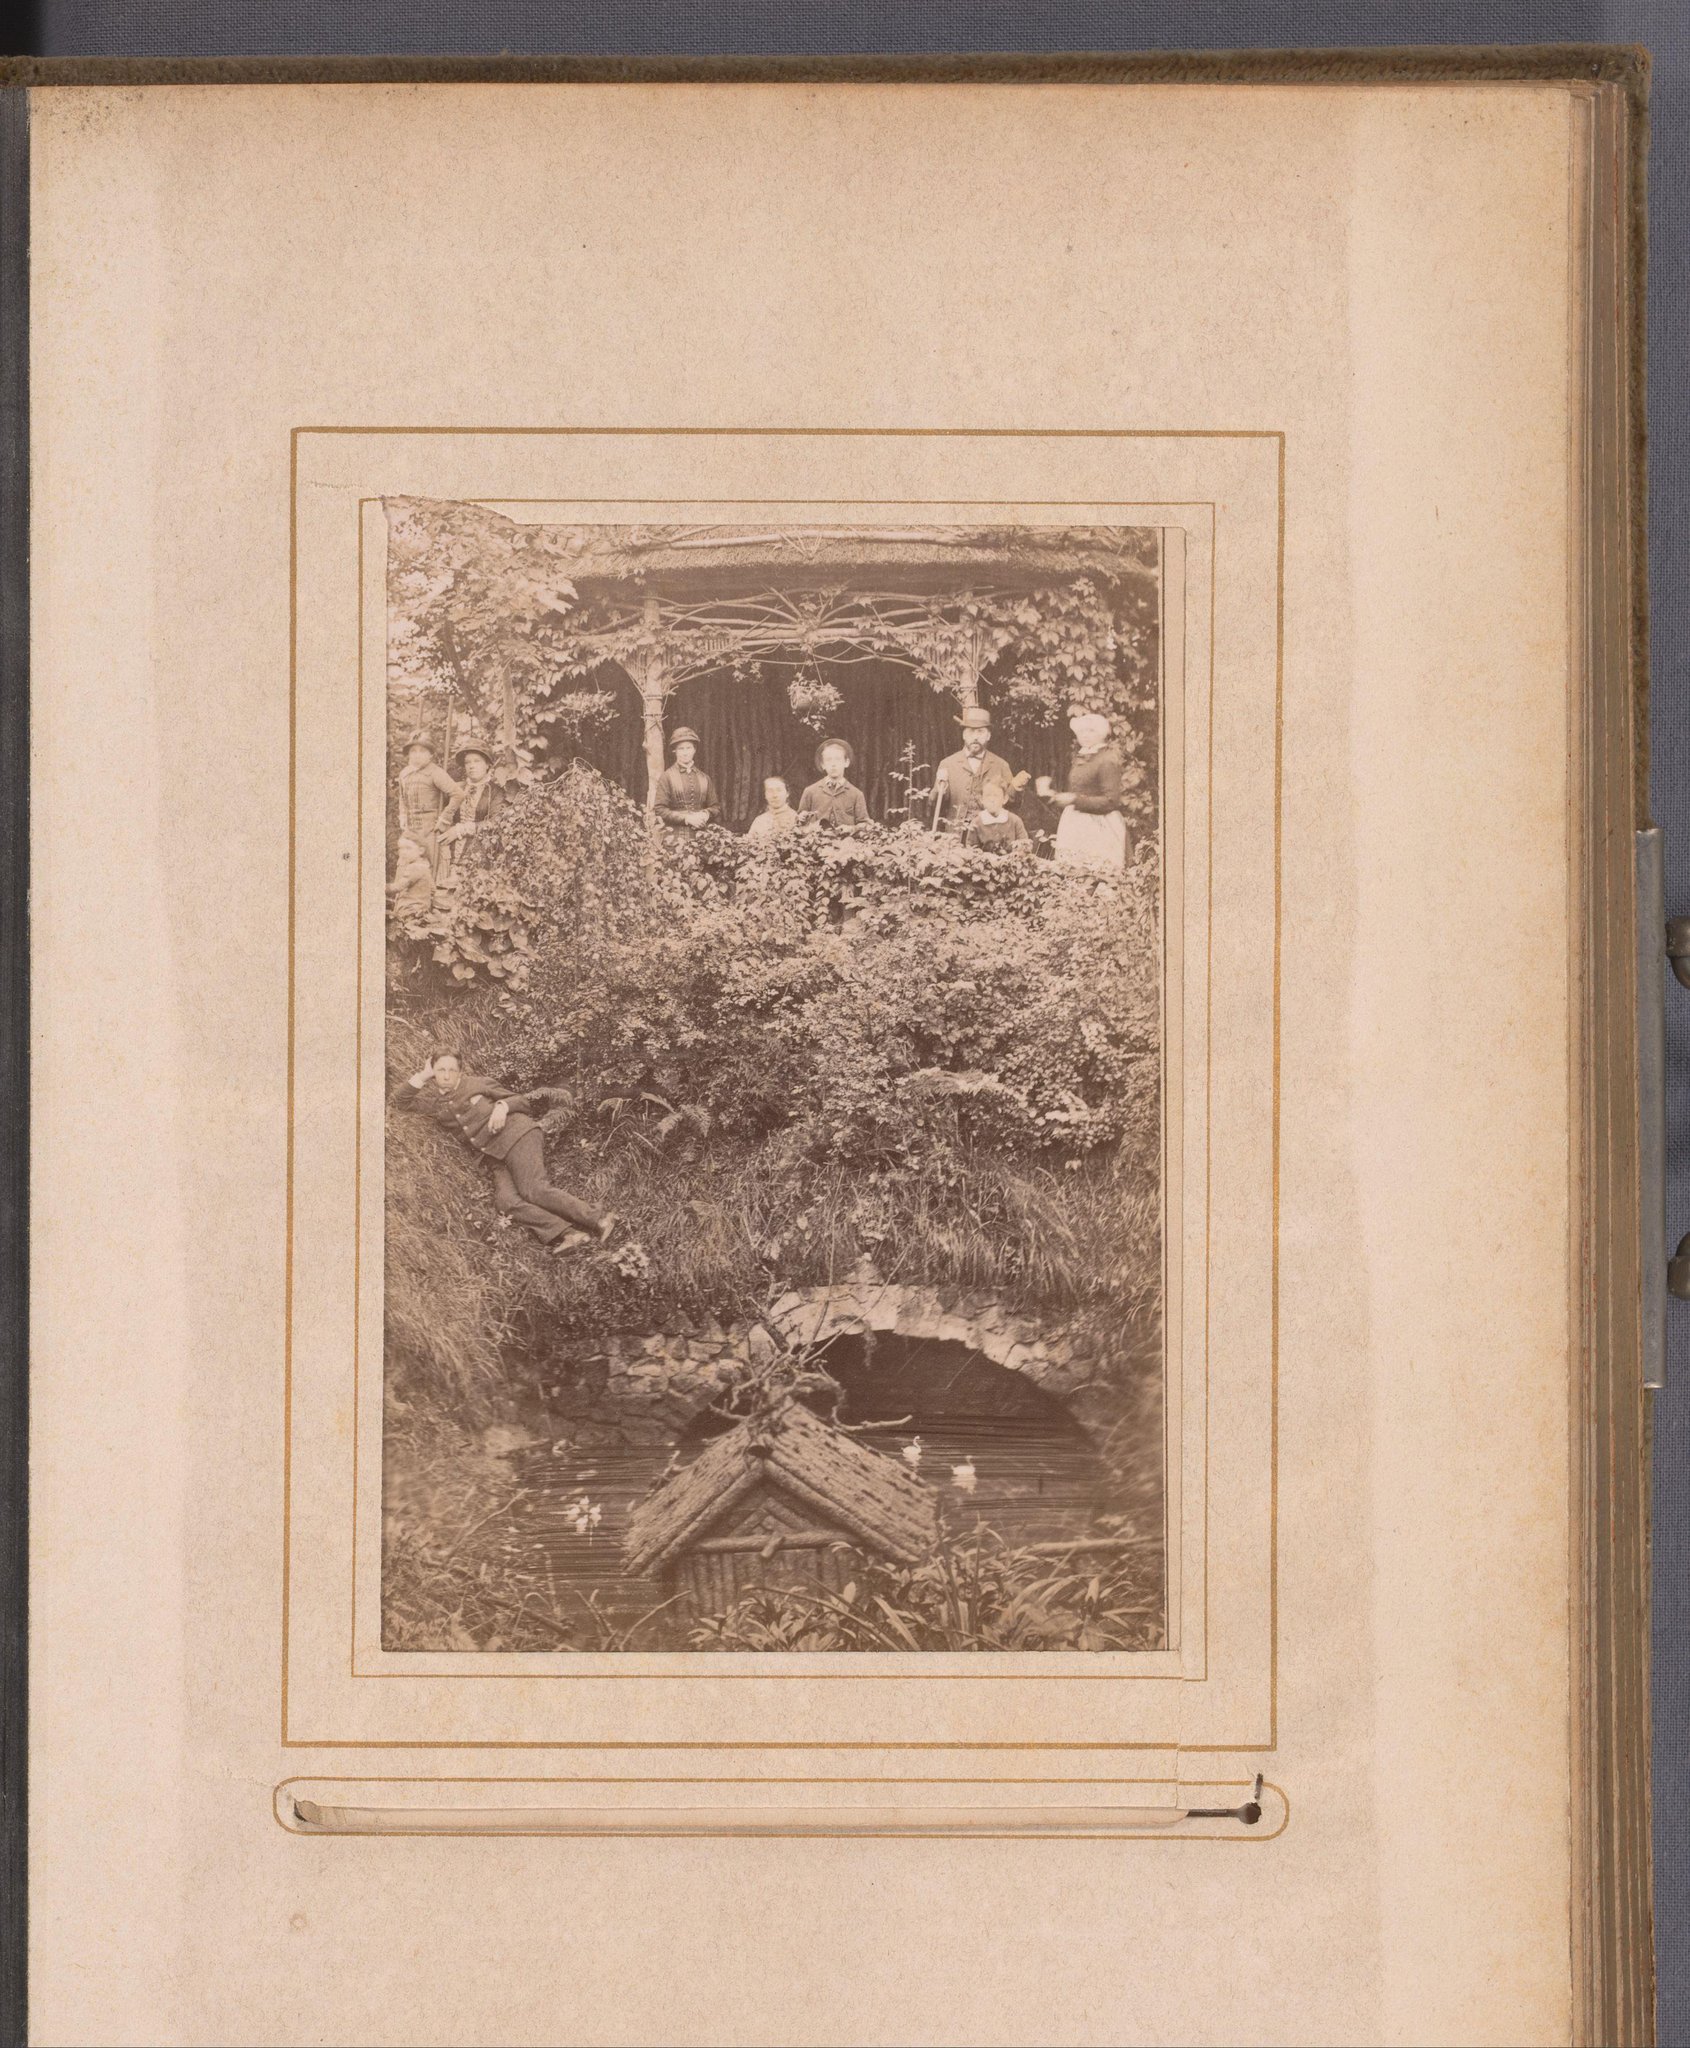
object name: photograph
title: Groepsportret in de tuin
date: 1881-1904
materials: cardboard, photographic support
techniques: albumen print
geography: arnhem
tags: anonymous historical persons portrayed in a group, in a group-portrait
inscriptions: inscription: ‘Brainich & Leusink/ Arnhem/ Menthensteeg No.7’